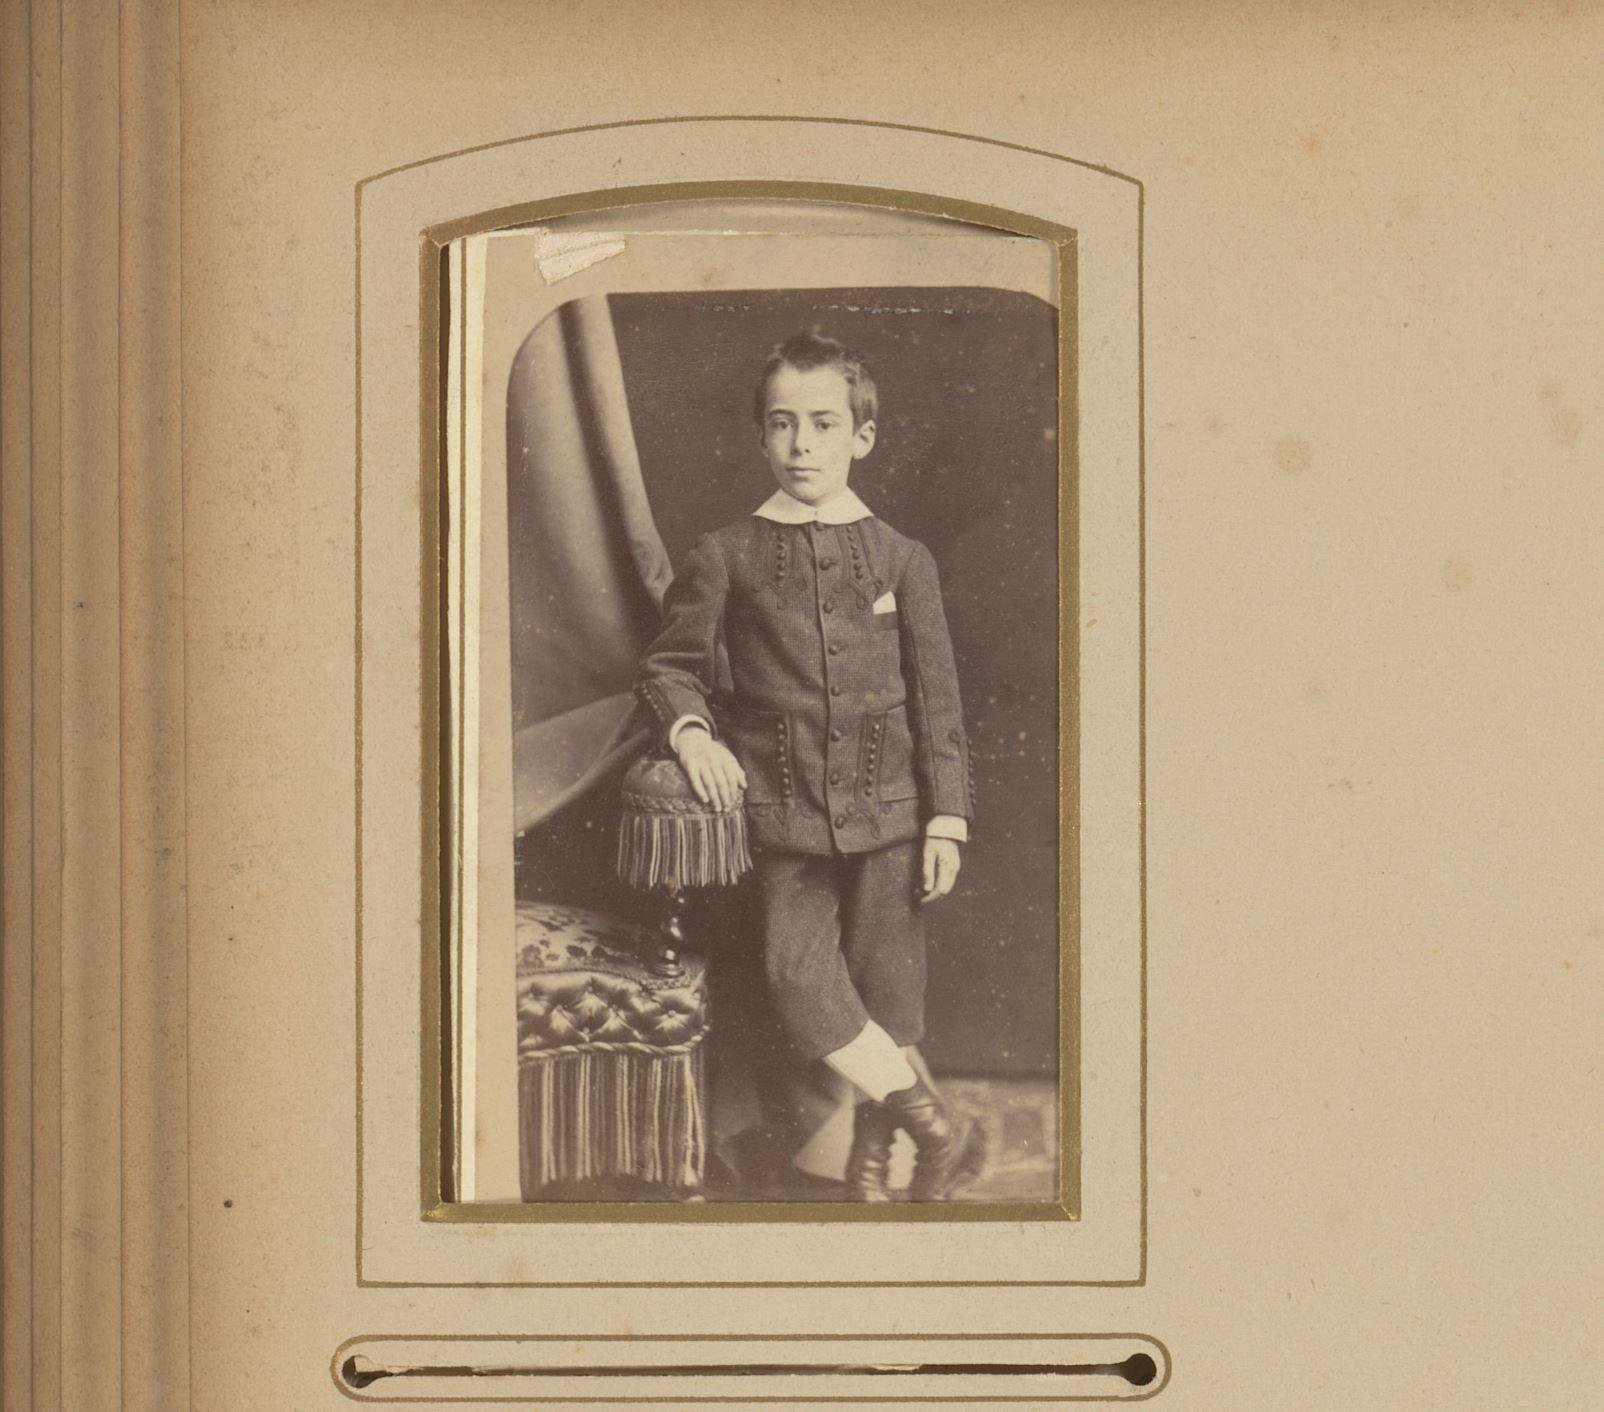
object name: photograph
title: Portret van een staande jongen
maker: jean-françois meeus-verbeke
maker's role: fotograaf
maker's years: 1845-1906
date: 1876-1890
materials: cardboard, photographic support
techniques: albumen print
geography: leuven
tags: standing figure, boy (child between toddler and youth), historical persons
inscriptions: inscription: ‘PHOTOGRAPHIE INALTÉRABLE/ Procédé au Charbon/ Meeus Verbeke/ 24, Rue de la Station, 24./ LOUVAIN/ Atelier de Pose au Premier./ [...] étant conservé, il suffit de/ [...]’